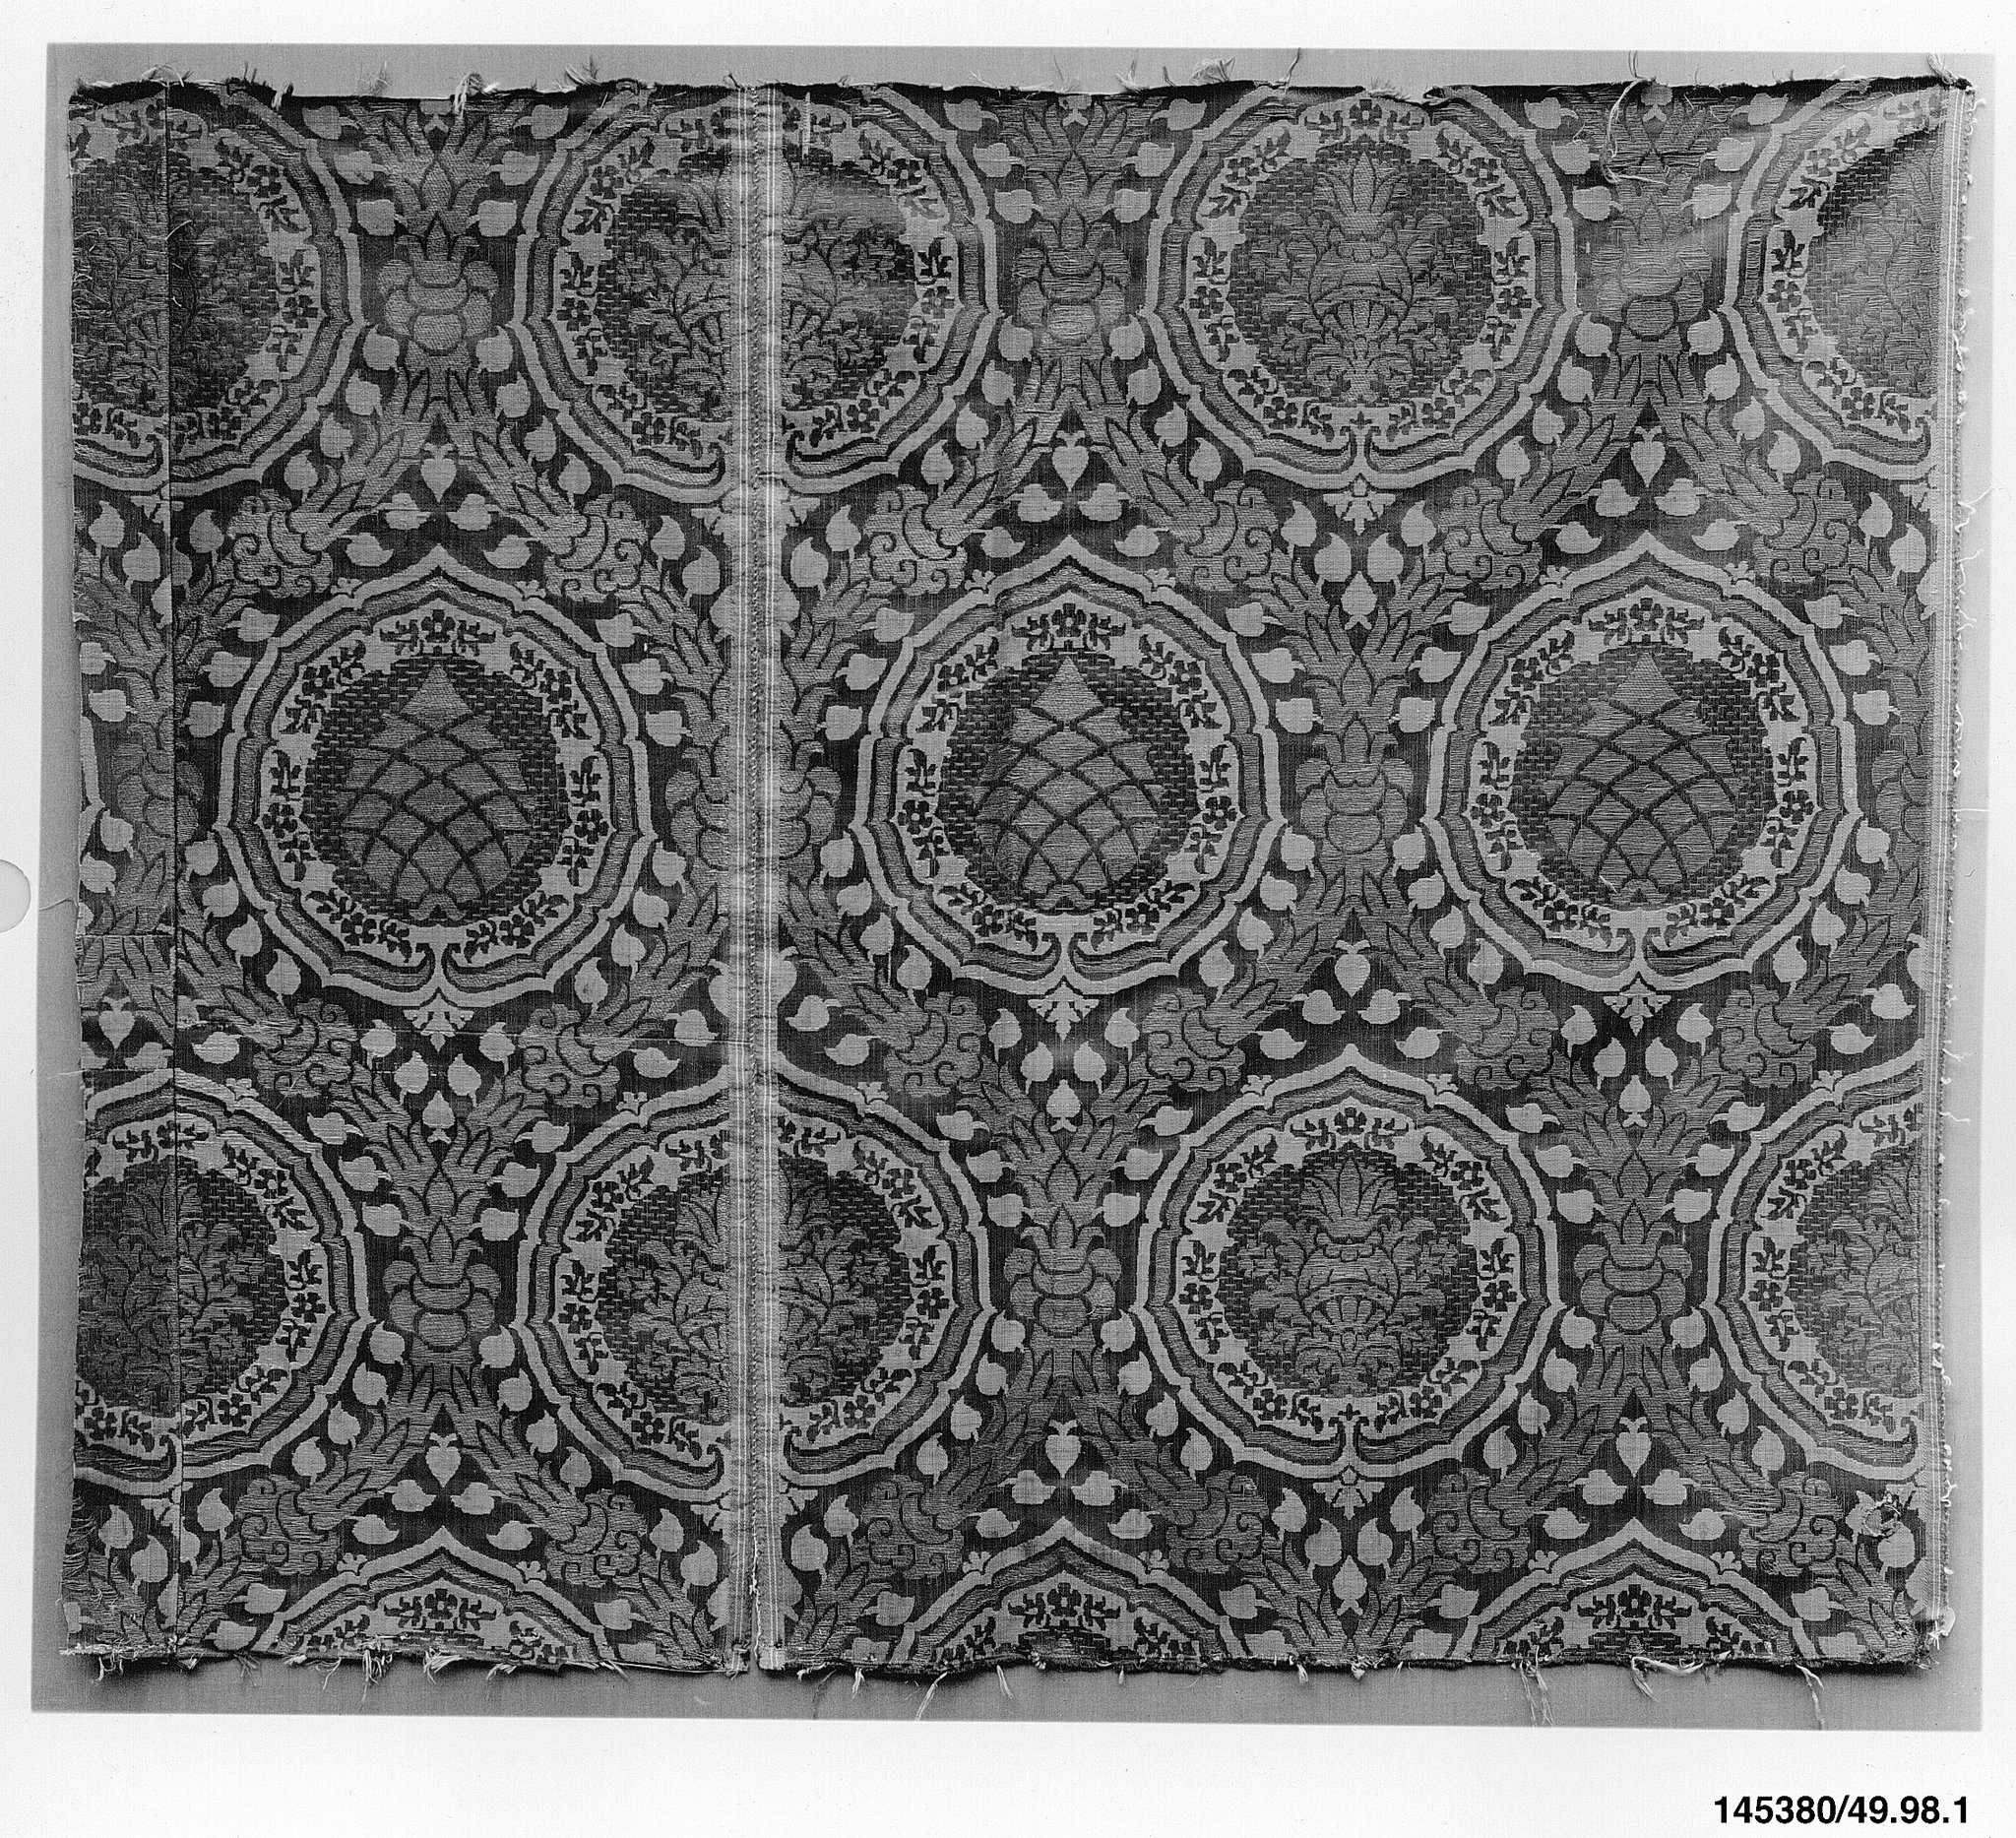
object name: piece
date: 1501-1600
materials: metal thread, silk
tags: flowers,leaves